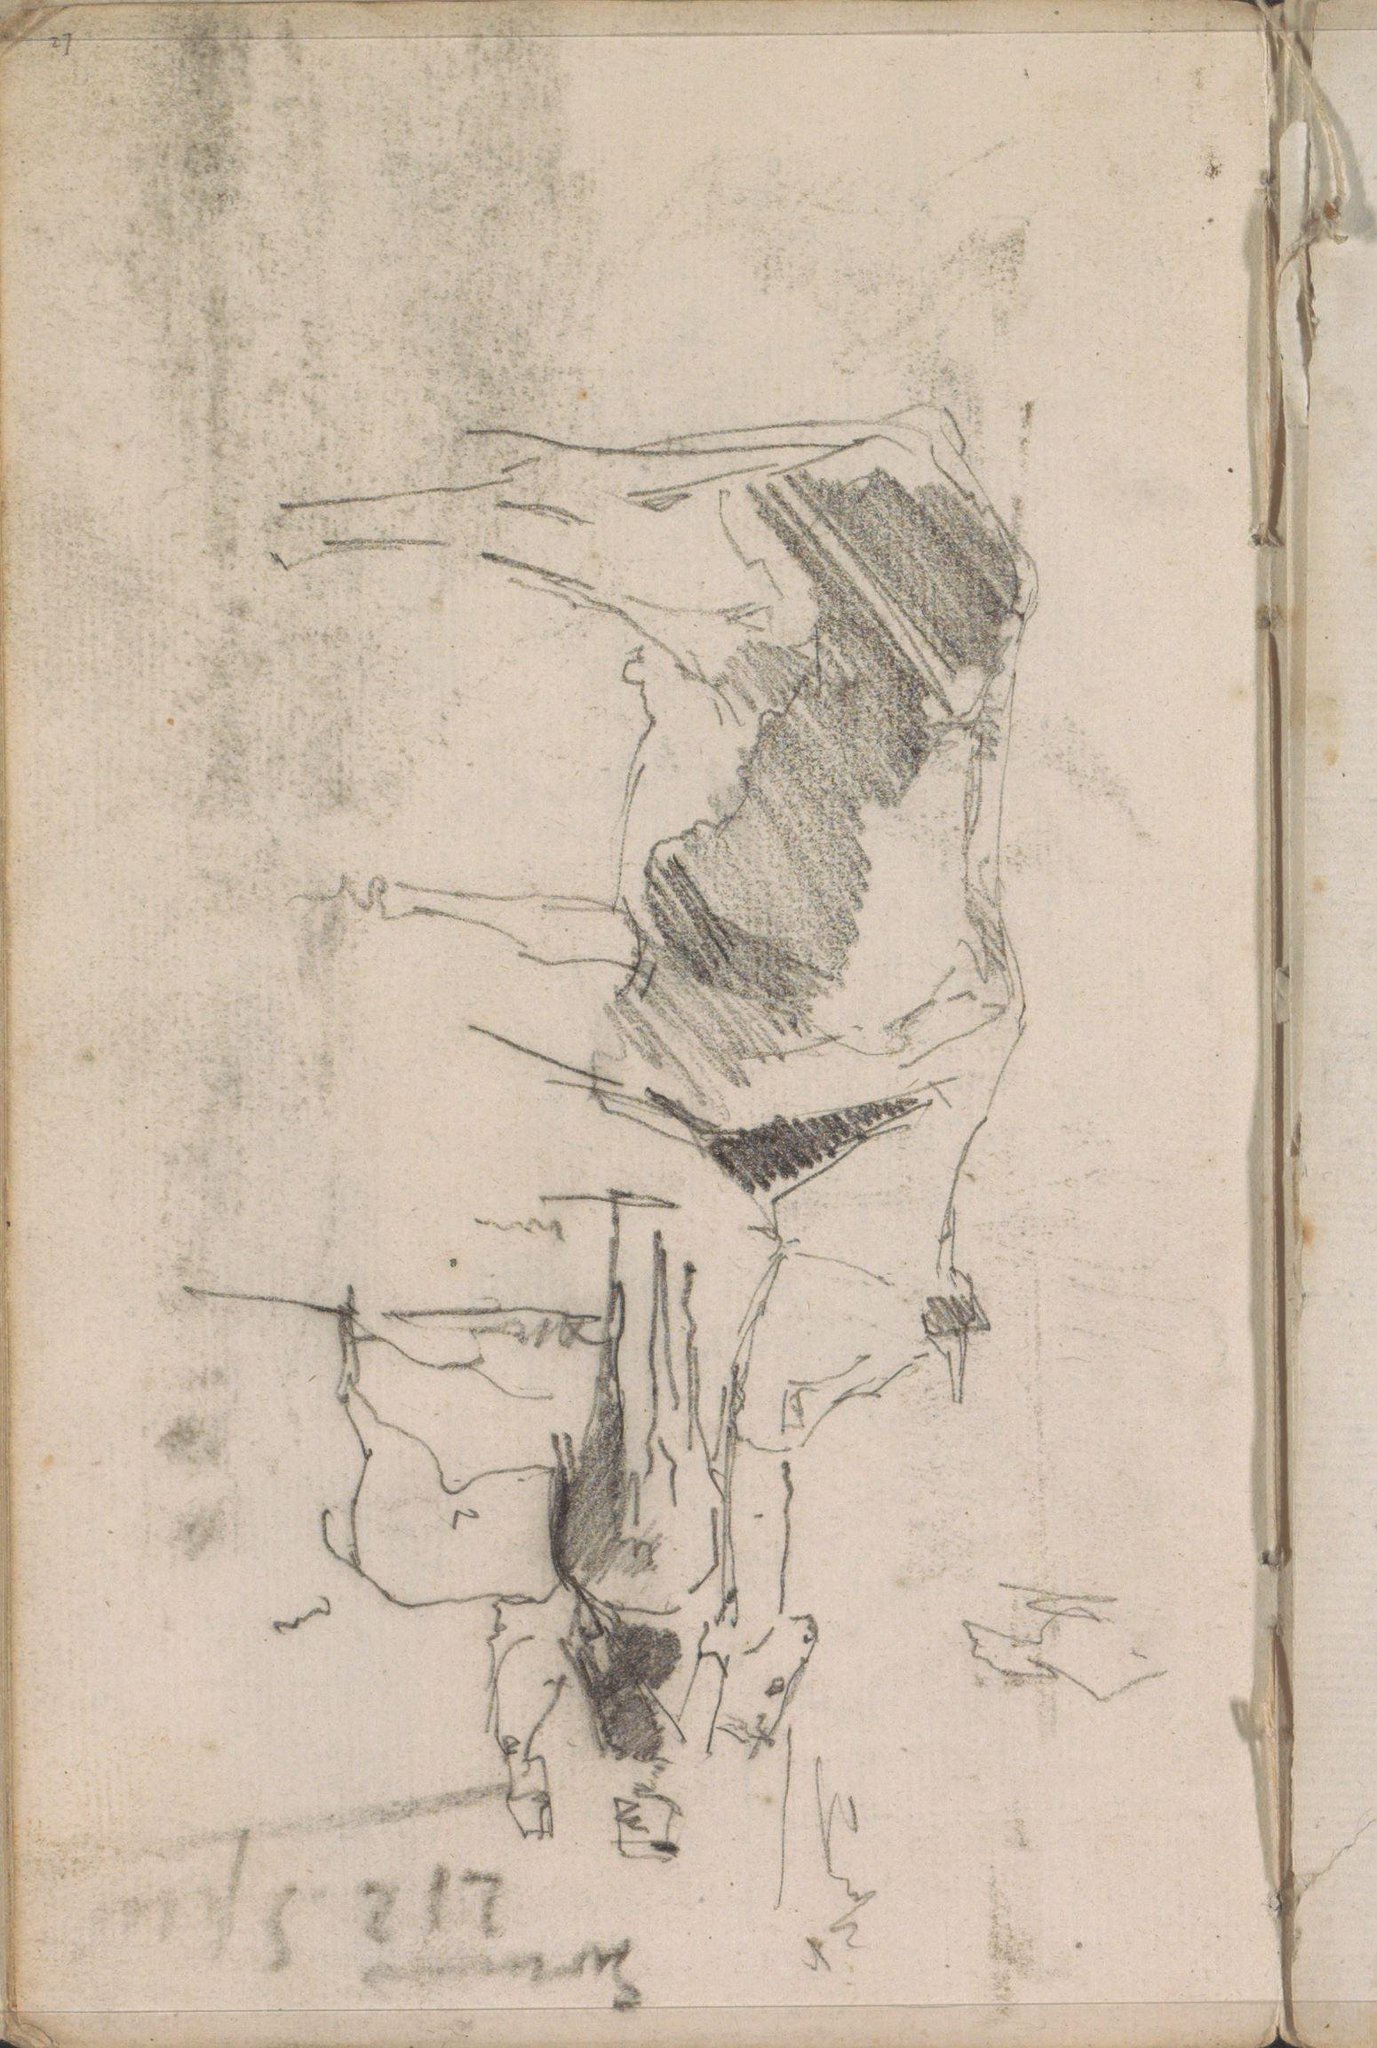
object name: sketchbook leaf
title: Staande koe en twee ruiters, mogelijk soldaten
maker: george hendrik breitner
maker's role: draughtsman, painter, print maker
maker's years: 1857-1923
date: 1880-1882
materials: chalk, paper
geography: the hague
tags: riding a horse, ass, or mule; rider, horseman, cow, division of armed forces (+ land forces)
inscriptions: annotation: ‘[...]’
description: Pagina 27 uit een schetsboek met 29 bladen.